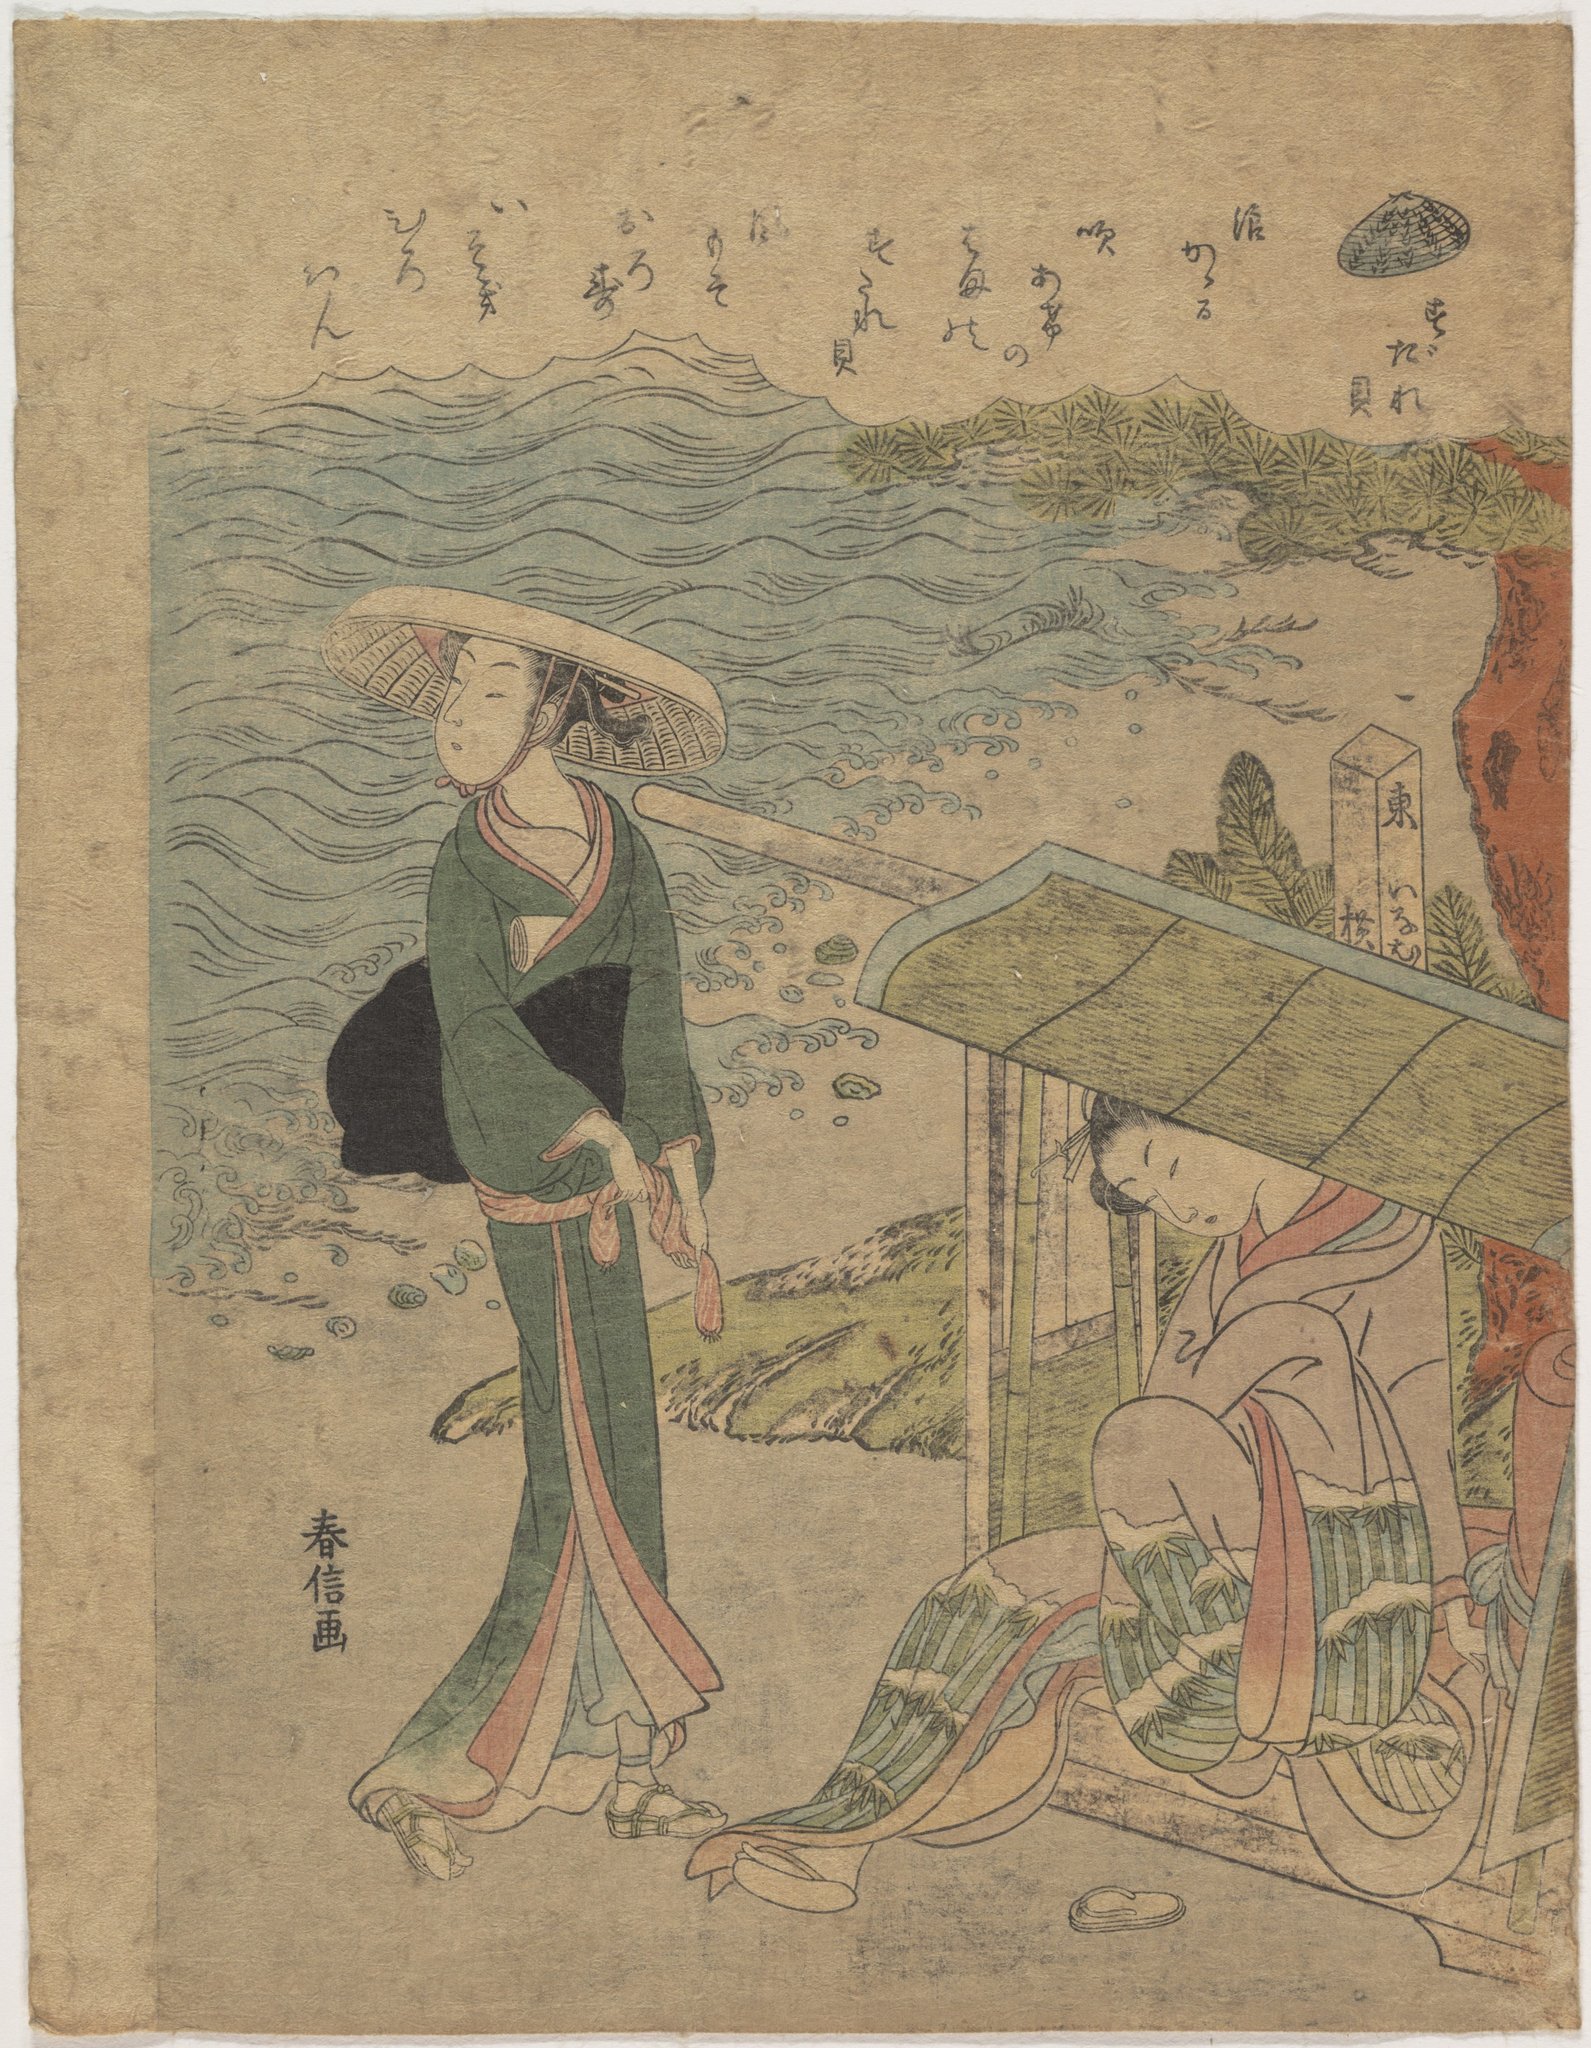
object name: print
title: The Curtain Clam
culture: japanese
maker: suzuki harunobu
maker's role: artist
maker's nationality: japanese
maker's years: 1725-1770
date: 1725-1770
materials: ink, paper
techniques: woodblock print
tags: women,beaches